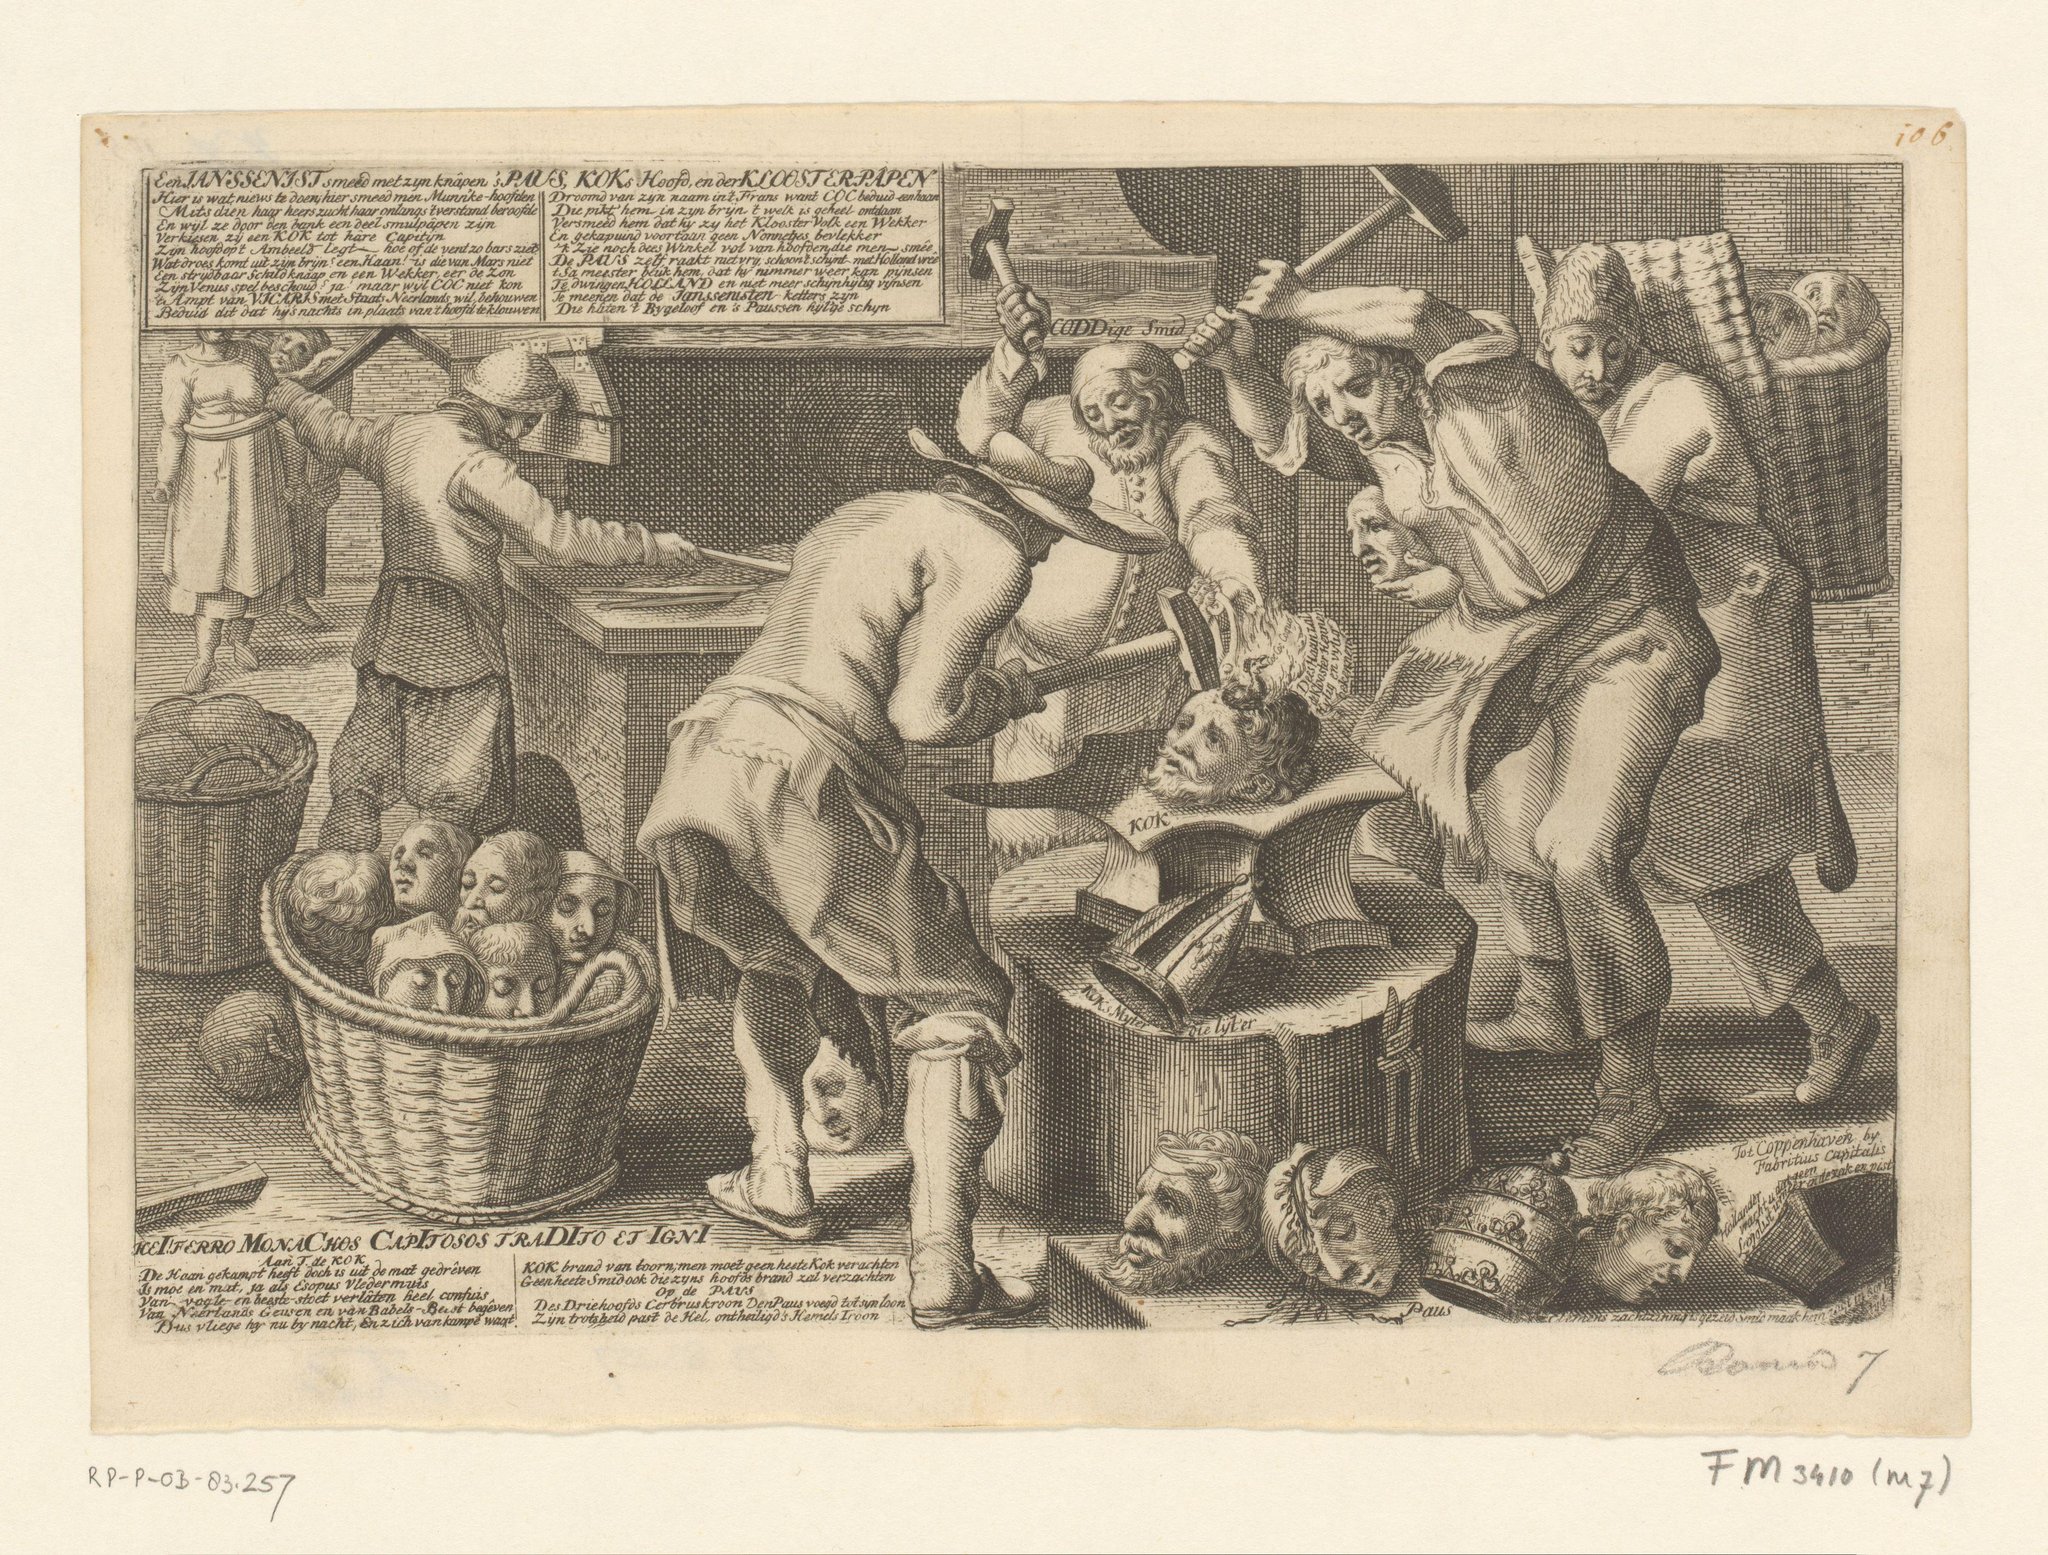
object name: cartoon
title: 7 Zinnebeeld, of de Hoofde-Smid der Munniken enz. Het Zevende Gebod overtreeden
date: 1592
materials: paper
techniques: engraving, etching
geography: amsterdam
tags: rome, utrecht, fire, oven, furnace ~ interior of industrial structure, smith, blacksmith, ways pretending to cure simpletons (folklore)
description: Het smeden van hoofden, 1705. In een smidse wordt het hoofd van Theodorus de Cock door drie smeden, waaronder Petrus Codde (de Coddige Smid) dusdanig met mokers bewerkt dat uit het hoofd een haantje tevoorschijn komt. Op de gronden hoofden van de paus en van een jezuïet. Zevende blad in de serie van 10 bladen met spotprenten op de jezuïeten getiteld Roma Pertubata, 1706.